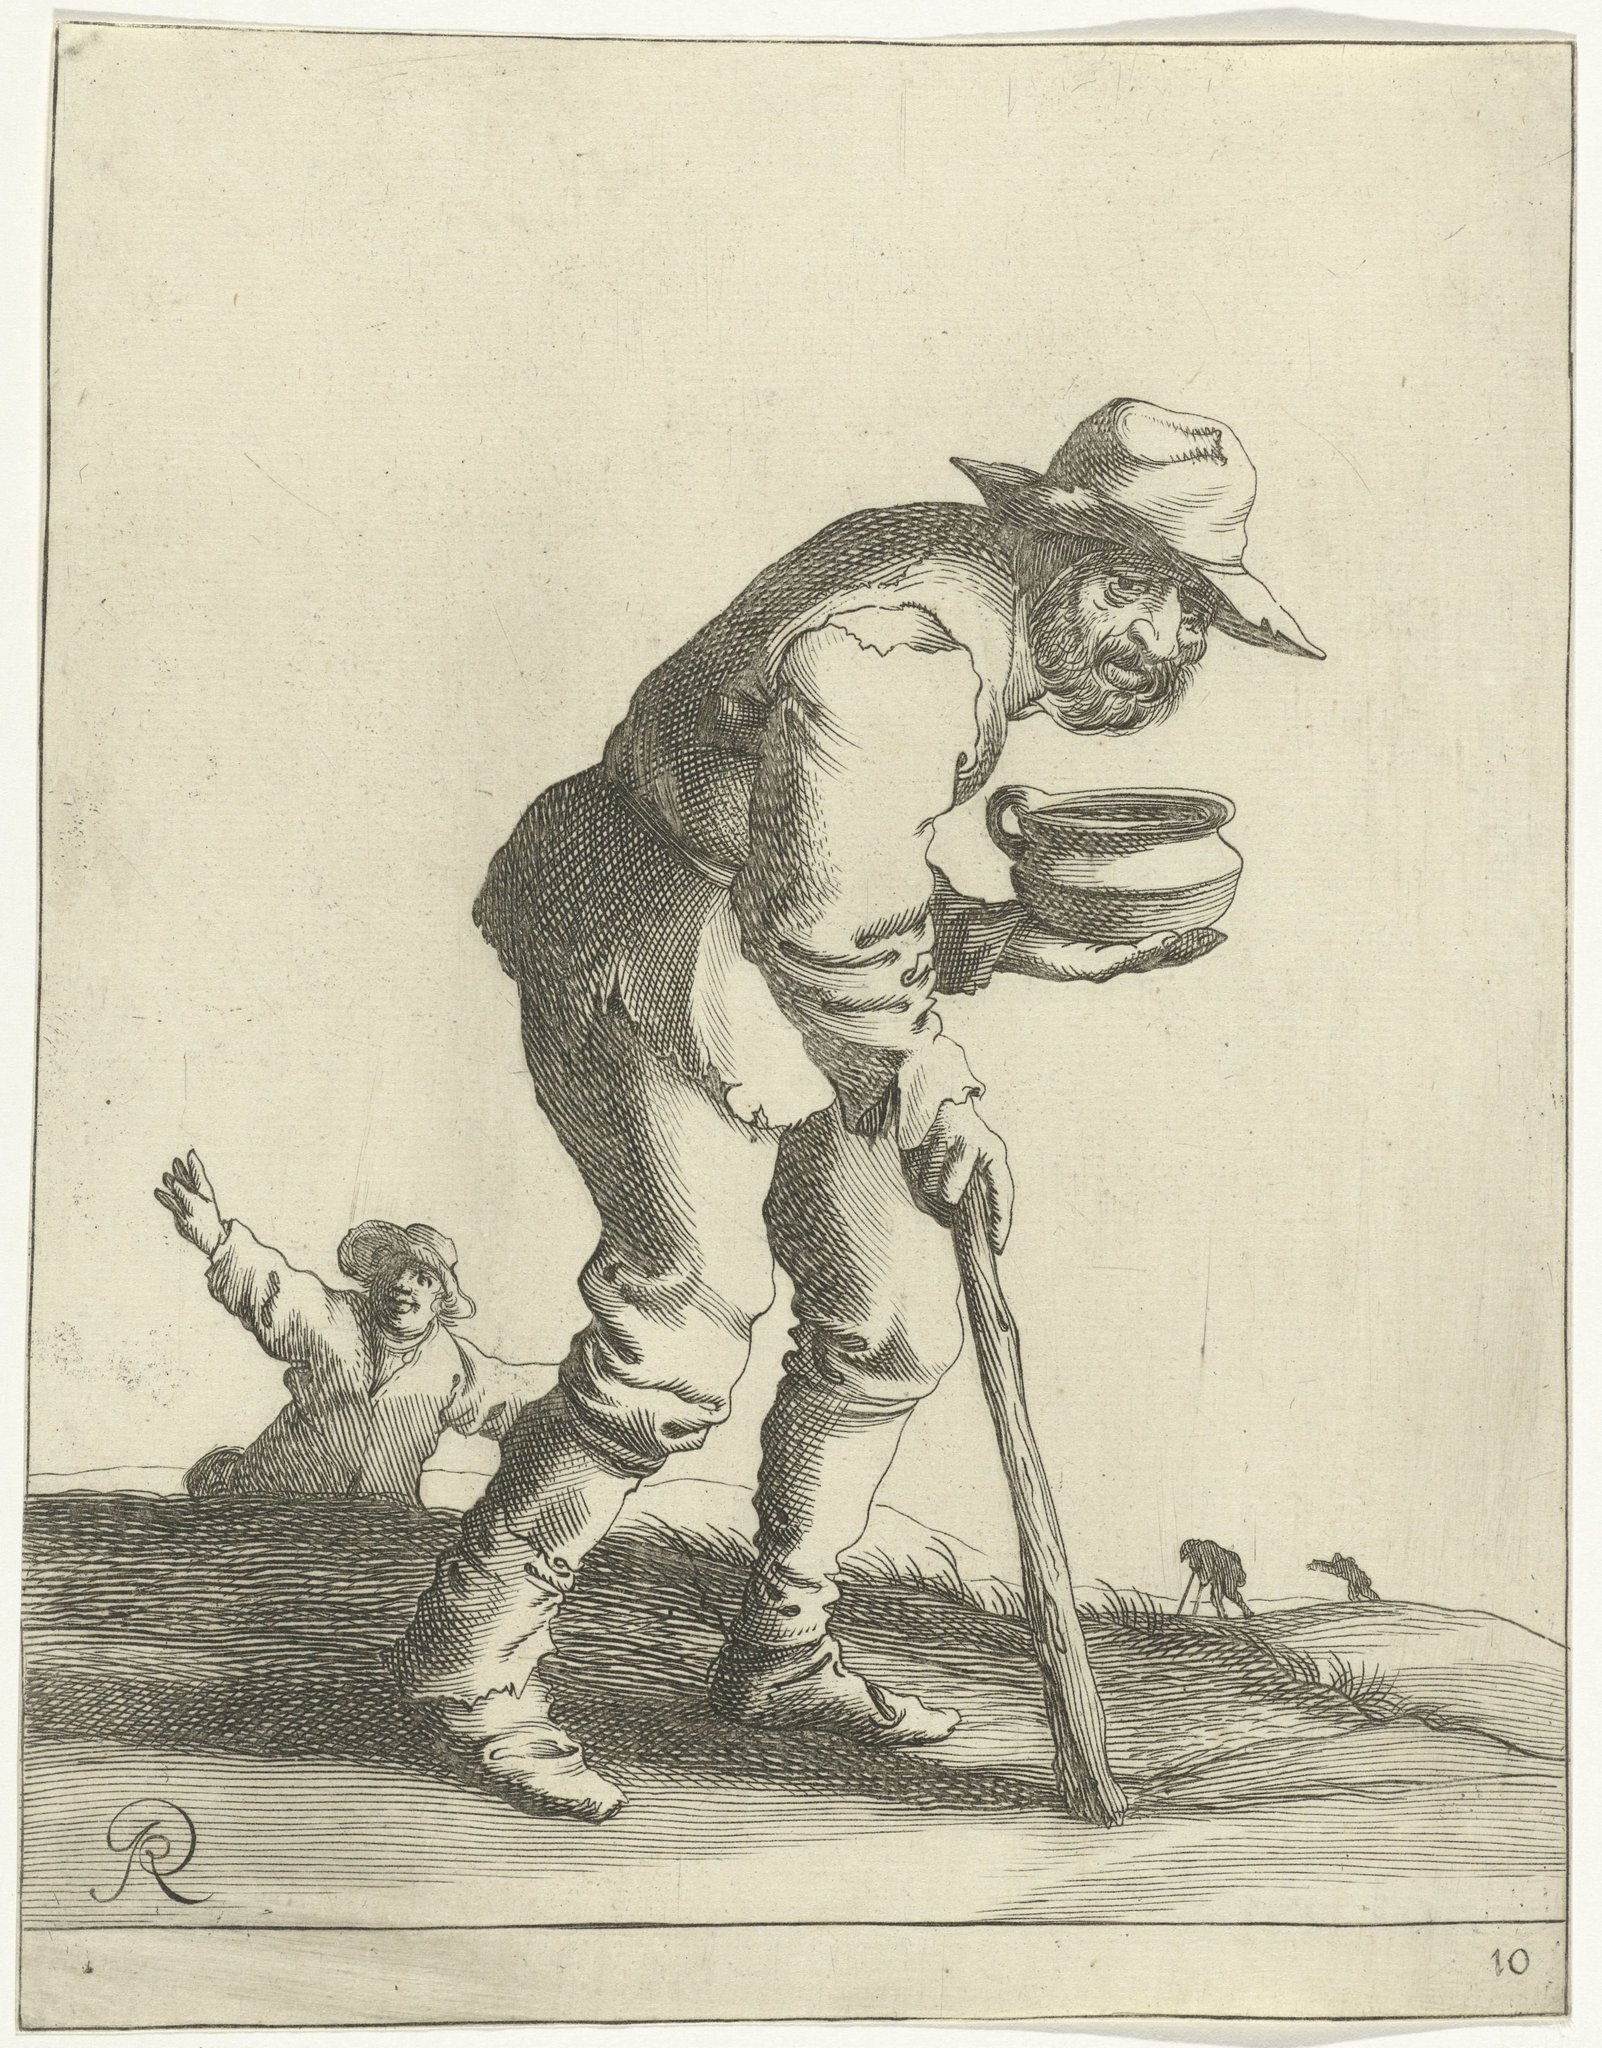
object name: print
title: Bedelaar met nap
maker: pieter jansz quast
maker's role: draughtsman, painter, print maker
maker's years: 1605-1647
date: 1634-1638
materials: paper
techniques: engraving, etching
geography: the hague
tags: crutches, begging bowl, beggar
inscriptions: collector's mark: Lugt 2228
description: Een bedelaar met een nap in zijn hand loopt leunend op een steunstok naar rechts. Links komt een man met zwaaiende armen op de bedelaar af. Rechts op de achtergrond twee andere landlopers. De prent maakt deel uit van een serie van zesentwintig prenten met bedelaars en boeren.